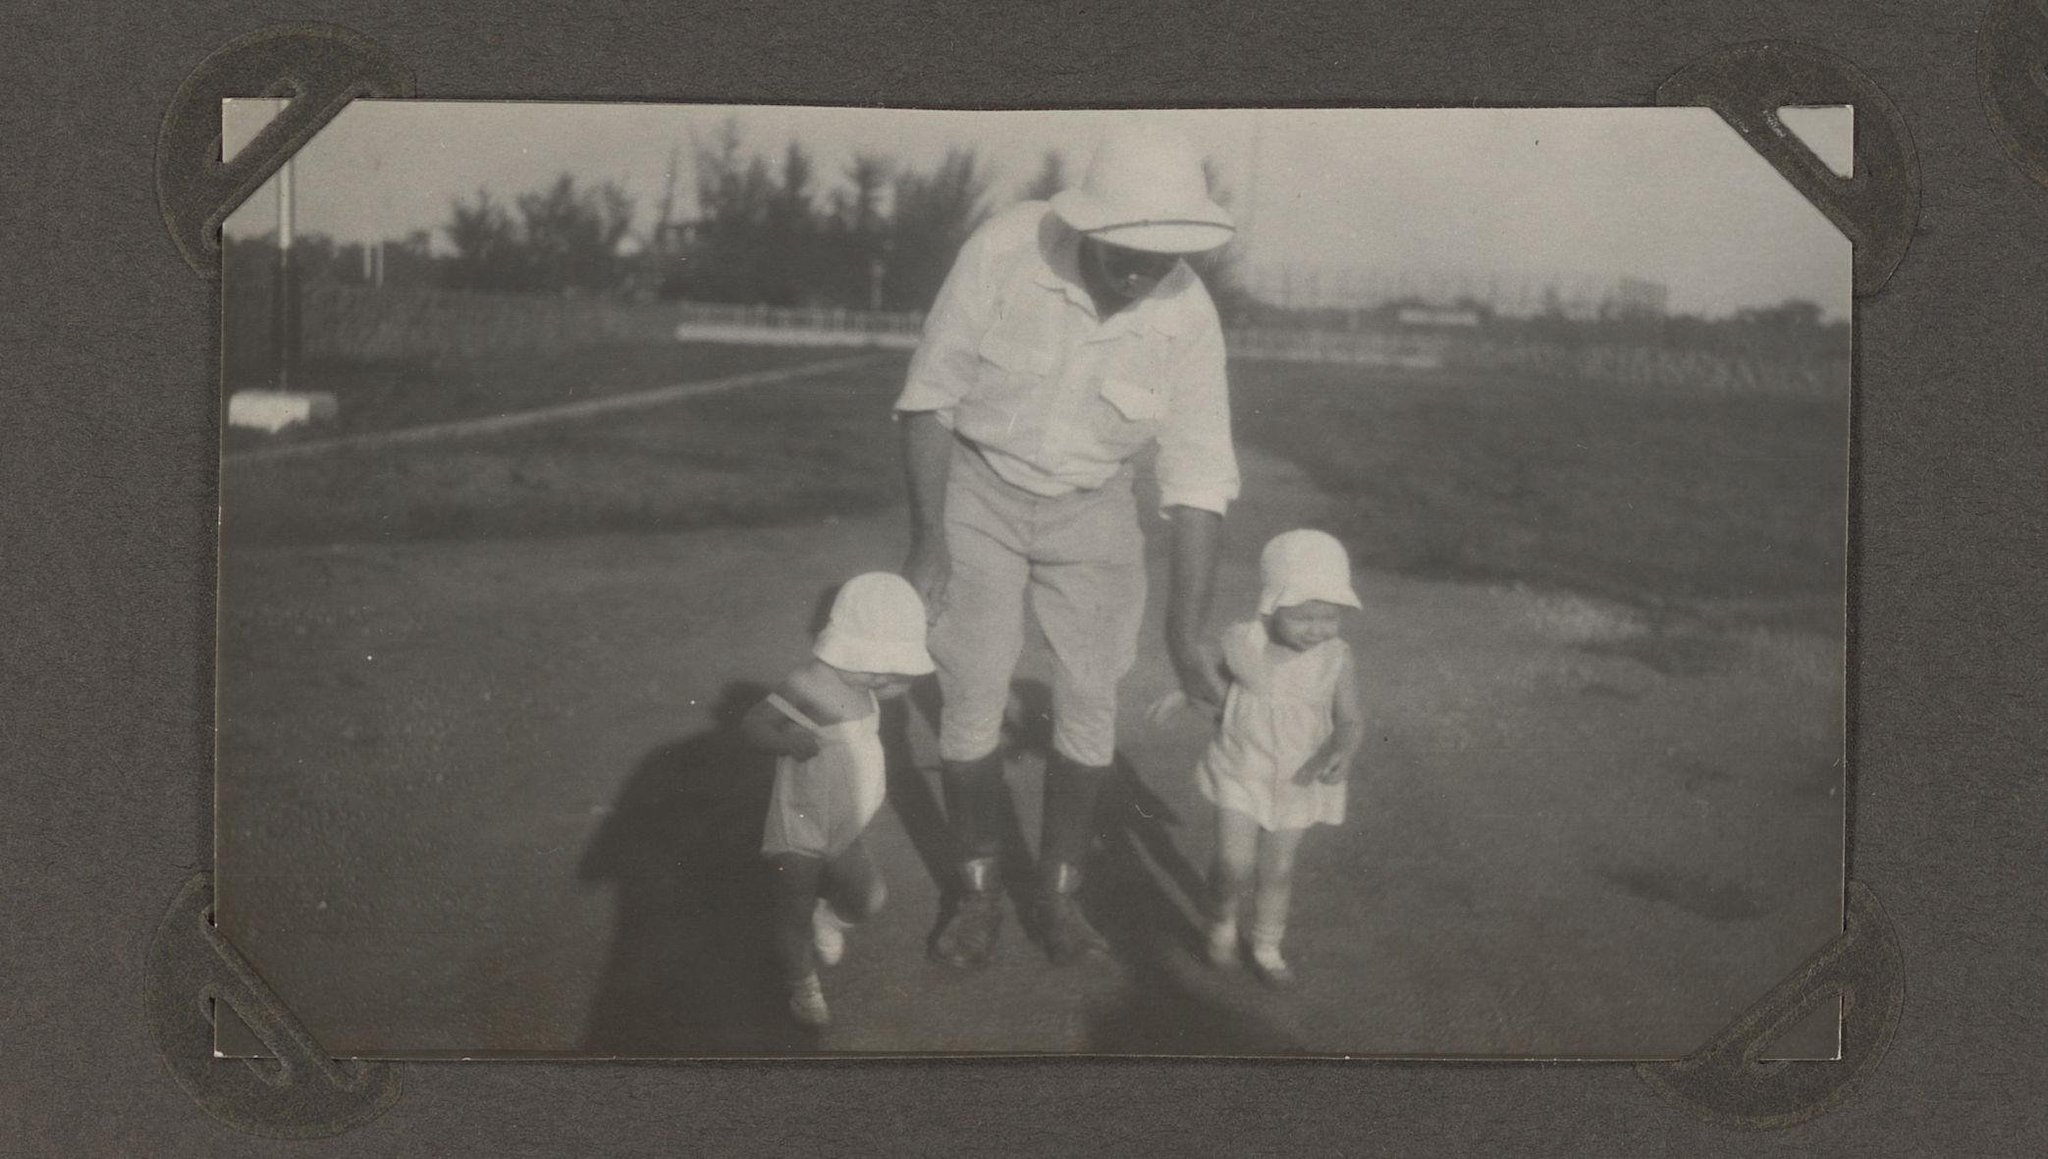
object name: photograph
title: Familiefoto van de kinderen Jetten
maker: Anonymous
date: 1925-1927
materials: photographic support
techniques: photography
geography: suriname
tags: jetten, familie, moengo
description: Familiefoto van de kinderen Jetten. Foto op een bladzijde van een los albumblad. Onderdeel van het ensemble met foto's van de familie van ingenieur Jetten in de mijnbouwstad Moengo in Suriname.